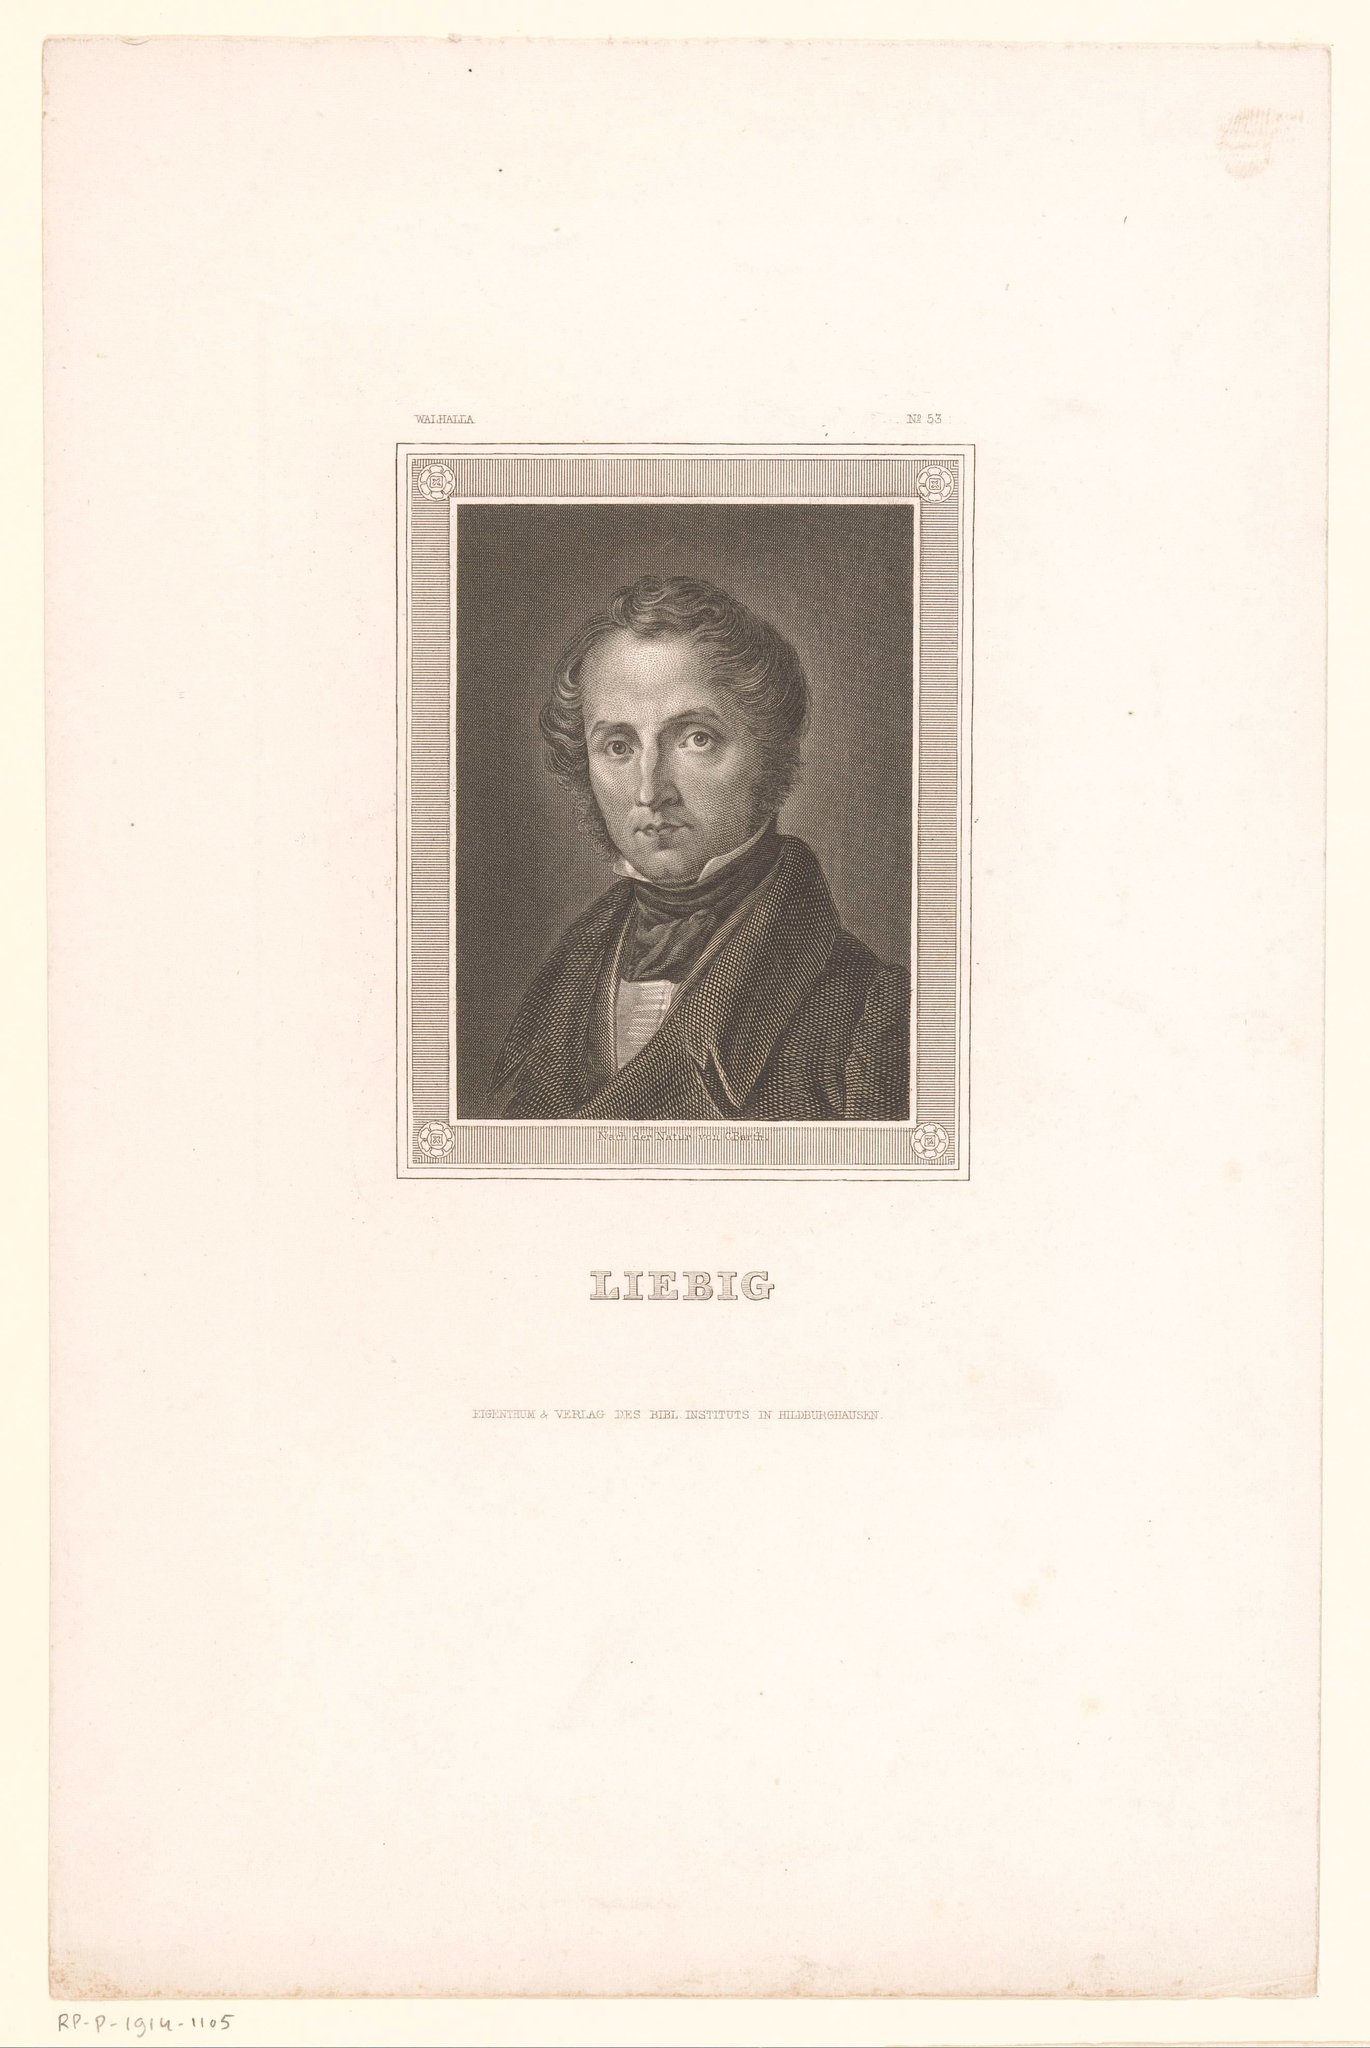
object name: print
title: Walhalla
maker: karl barth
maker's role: print maker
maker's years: 1787-1853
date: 1828-1853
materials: paper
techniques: engraving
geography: hildburghausen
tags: historical persons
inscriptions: collector's mark: Lugt 2228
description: Prent uitgegeven in de portretserie 'Walhalla, eine Gallerie der Bildnisse der Zierden des Menschengeschlechts'.